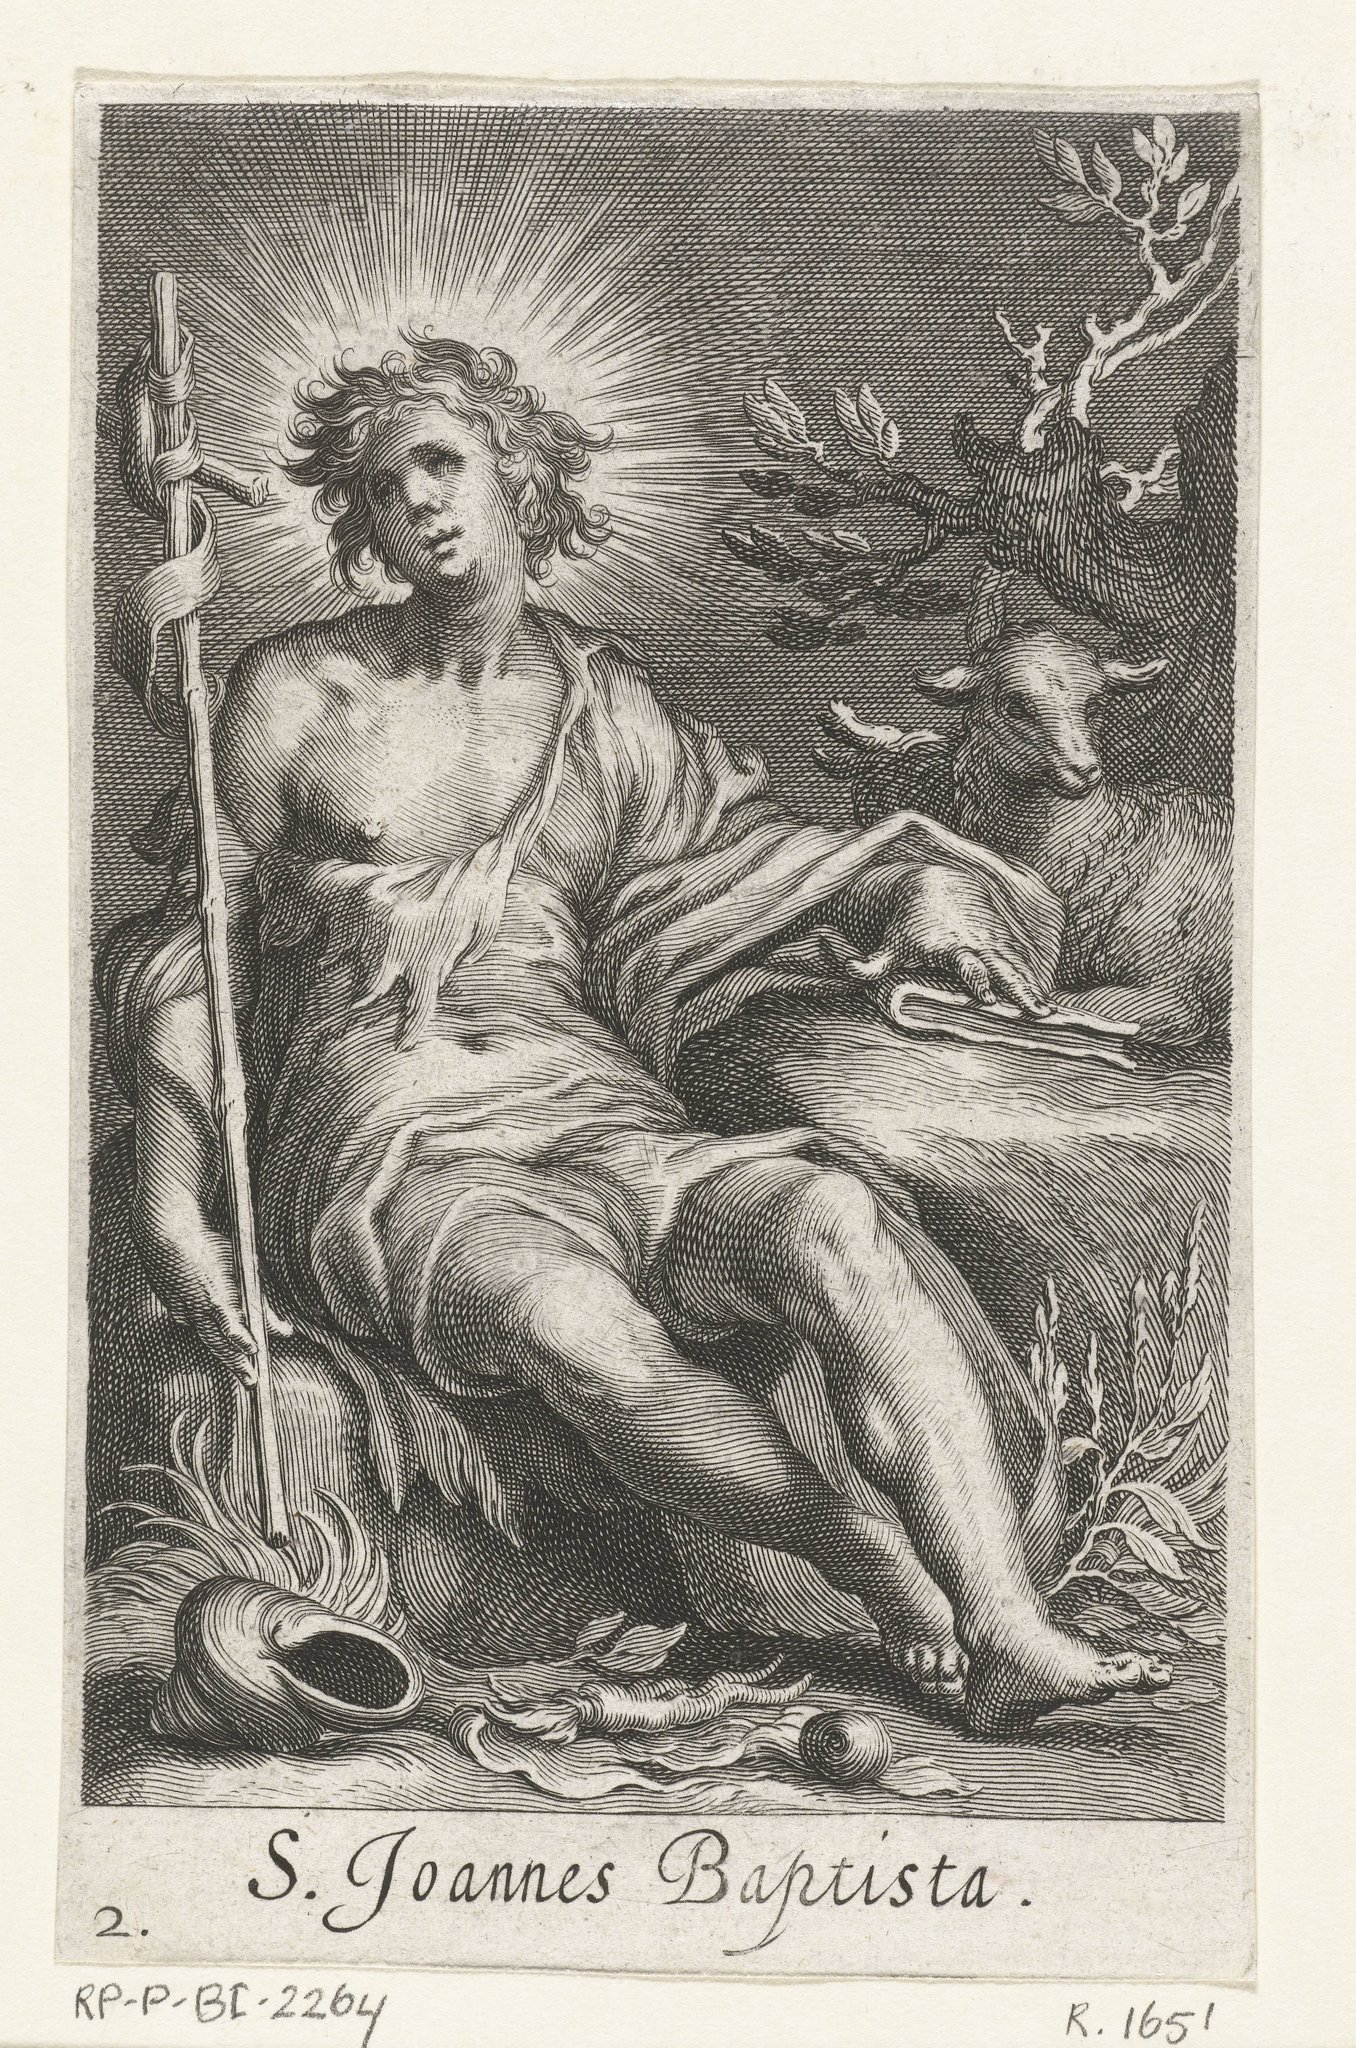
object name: book illustration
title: Kluizenaars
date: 1590-1612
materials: paper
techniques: engraving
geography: antwerp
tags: john the baptist; possible attributes: book, reed cross, baptismal cup, honeycomb, lamb, staff, anchorite, hermit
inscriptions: collector's mark: Lugt 240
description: Prent uit: Sacra eremus ascetarum, Antwerpen, Hendrick Aertssen, 1619. Eerste gebonden uitgave met in totaal vijftig prenten. Prent uit serie van vijfentwintig mannelijke kluizenaars. In 1612 verscheen een ongebonden editie maar op basis van de gewijzigde opschriften en samenstelling wordt aangenomen dat de prenten van de uitgave 1619 ook in 1612 of iets daarvoor gedrukt werden. Roethlisberger beschouwt de uitgave van 1619 als de eerste staat en de ongebonden editie van 1612 als de tweede staat (Roethlisberger 1993, p. 171, 172).